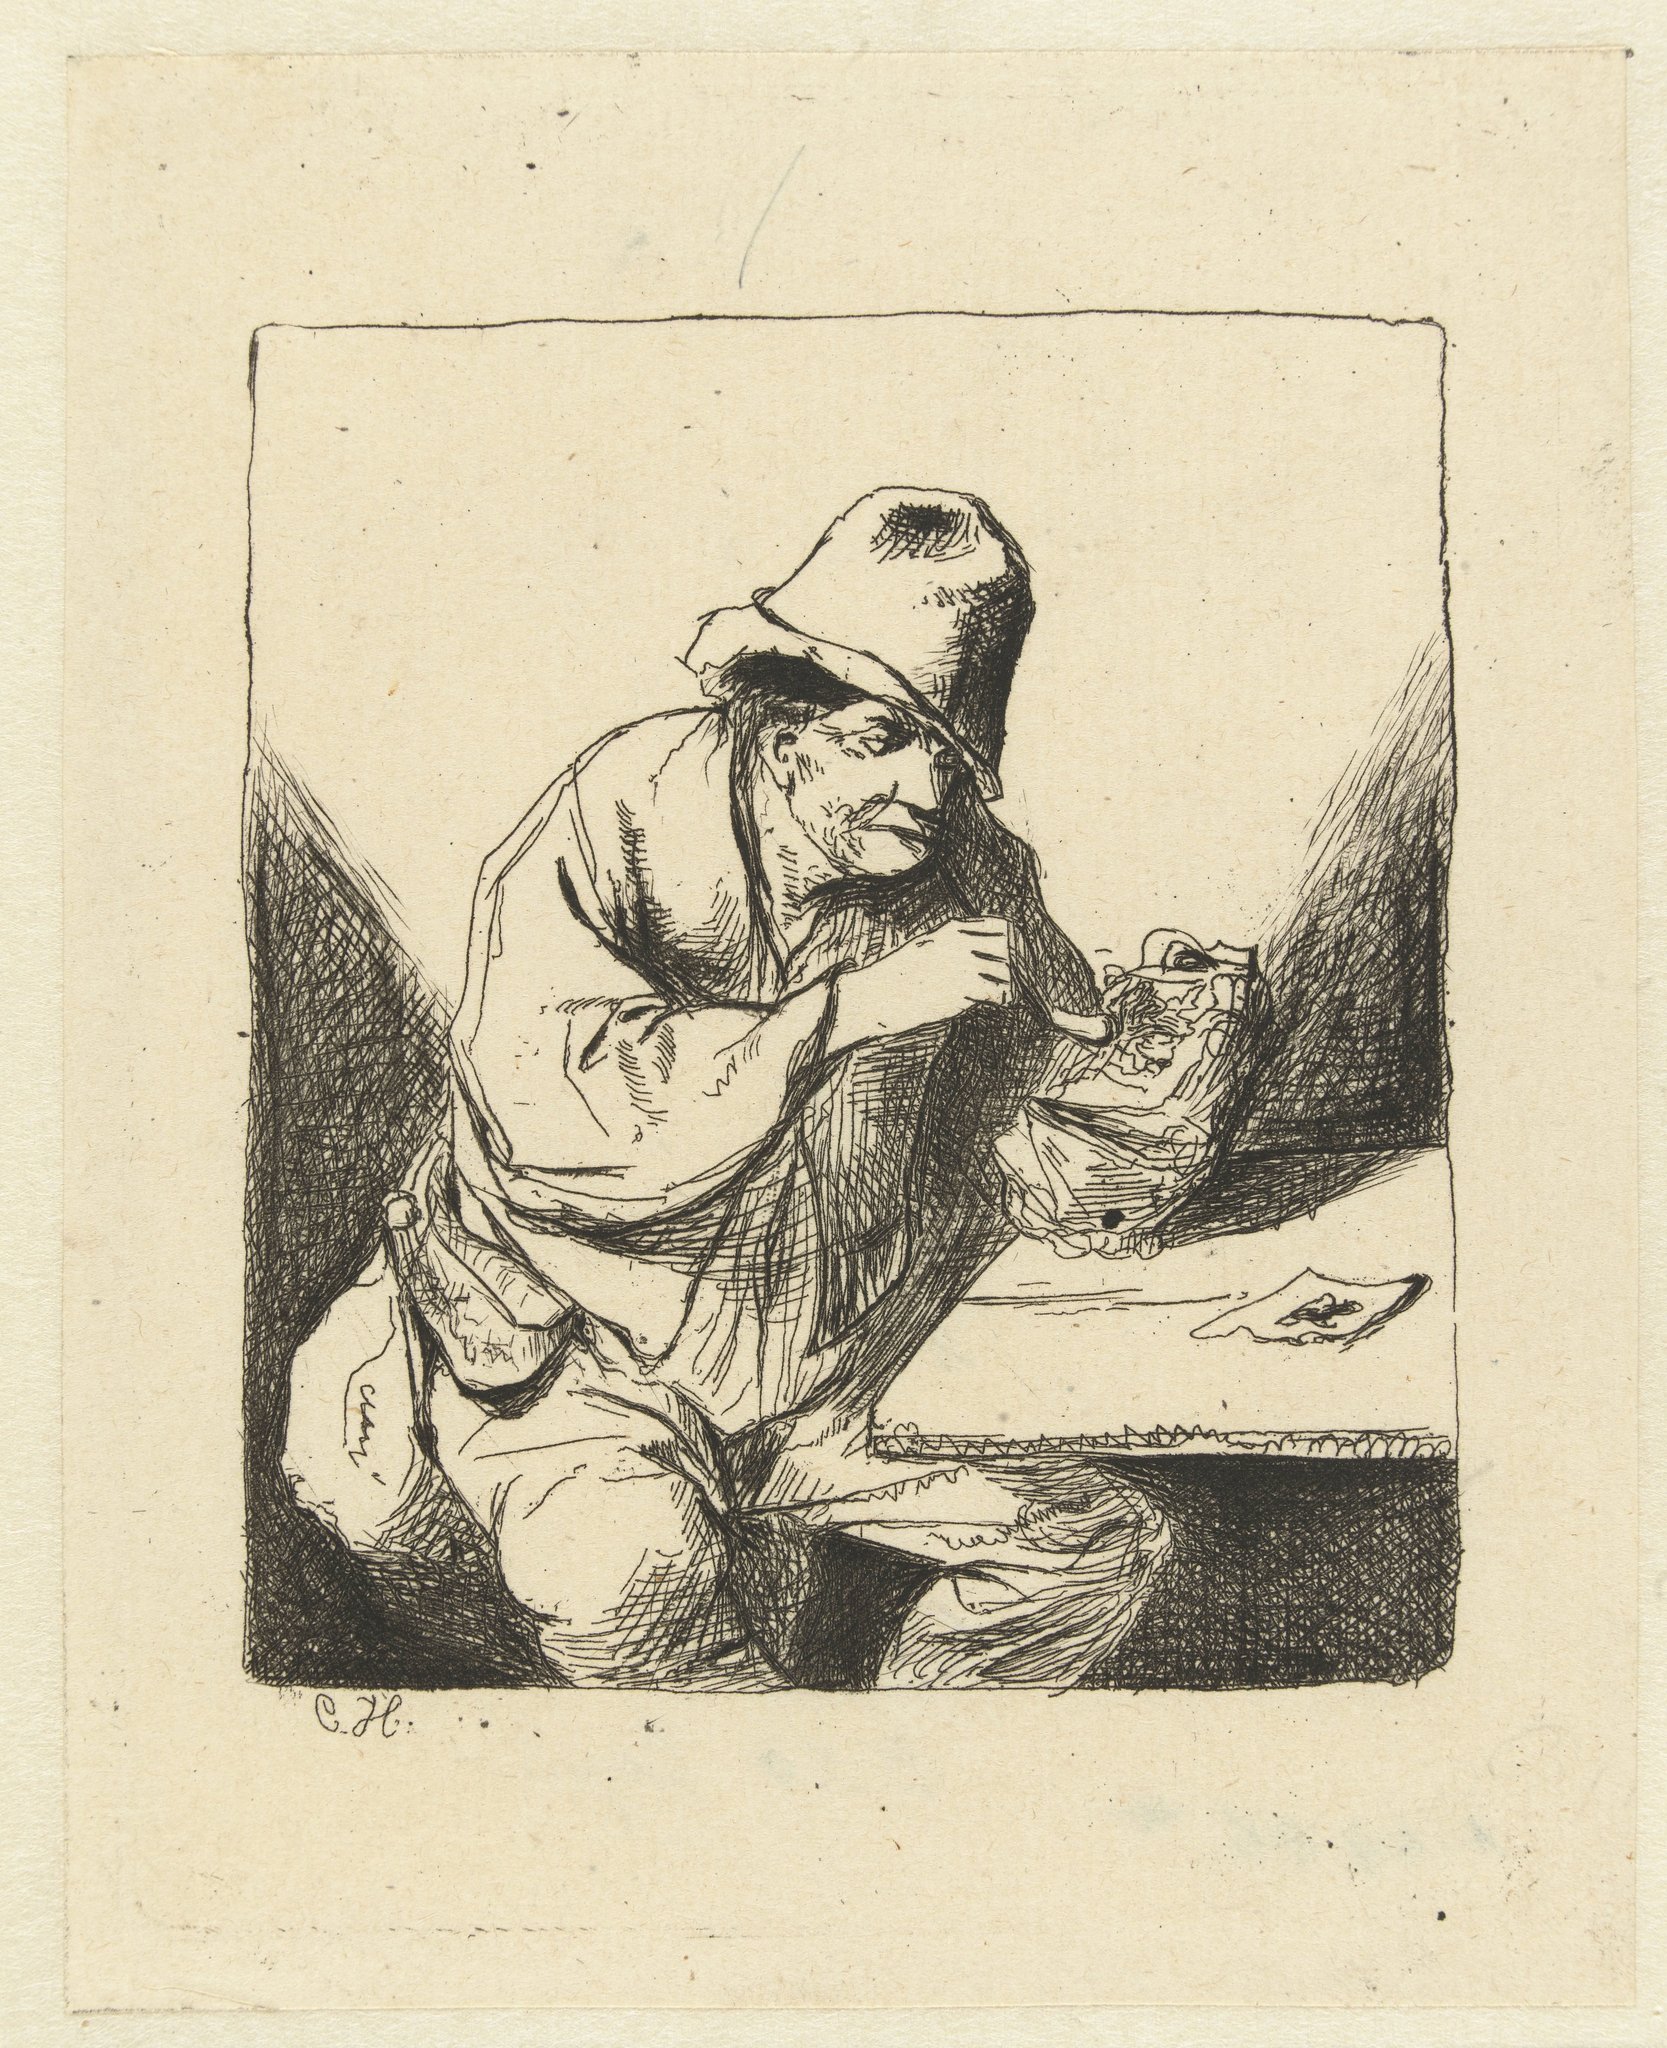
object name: kopie naar prent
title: Zittende man steekt pijp aan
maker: monogrammist ch (graveur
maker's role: print maker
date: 1642-1714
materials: paper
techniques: etching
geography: netherlands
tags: pipe ~ tobacco, male sex; man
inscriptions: collector's mark: Lugt 2228a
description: Kopie in spiegelbeeld naar prent van Cornelis Pietersz. Bega